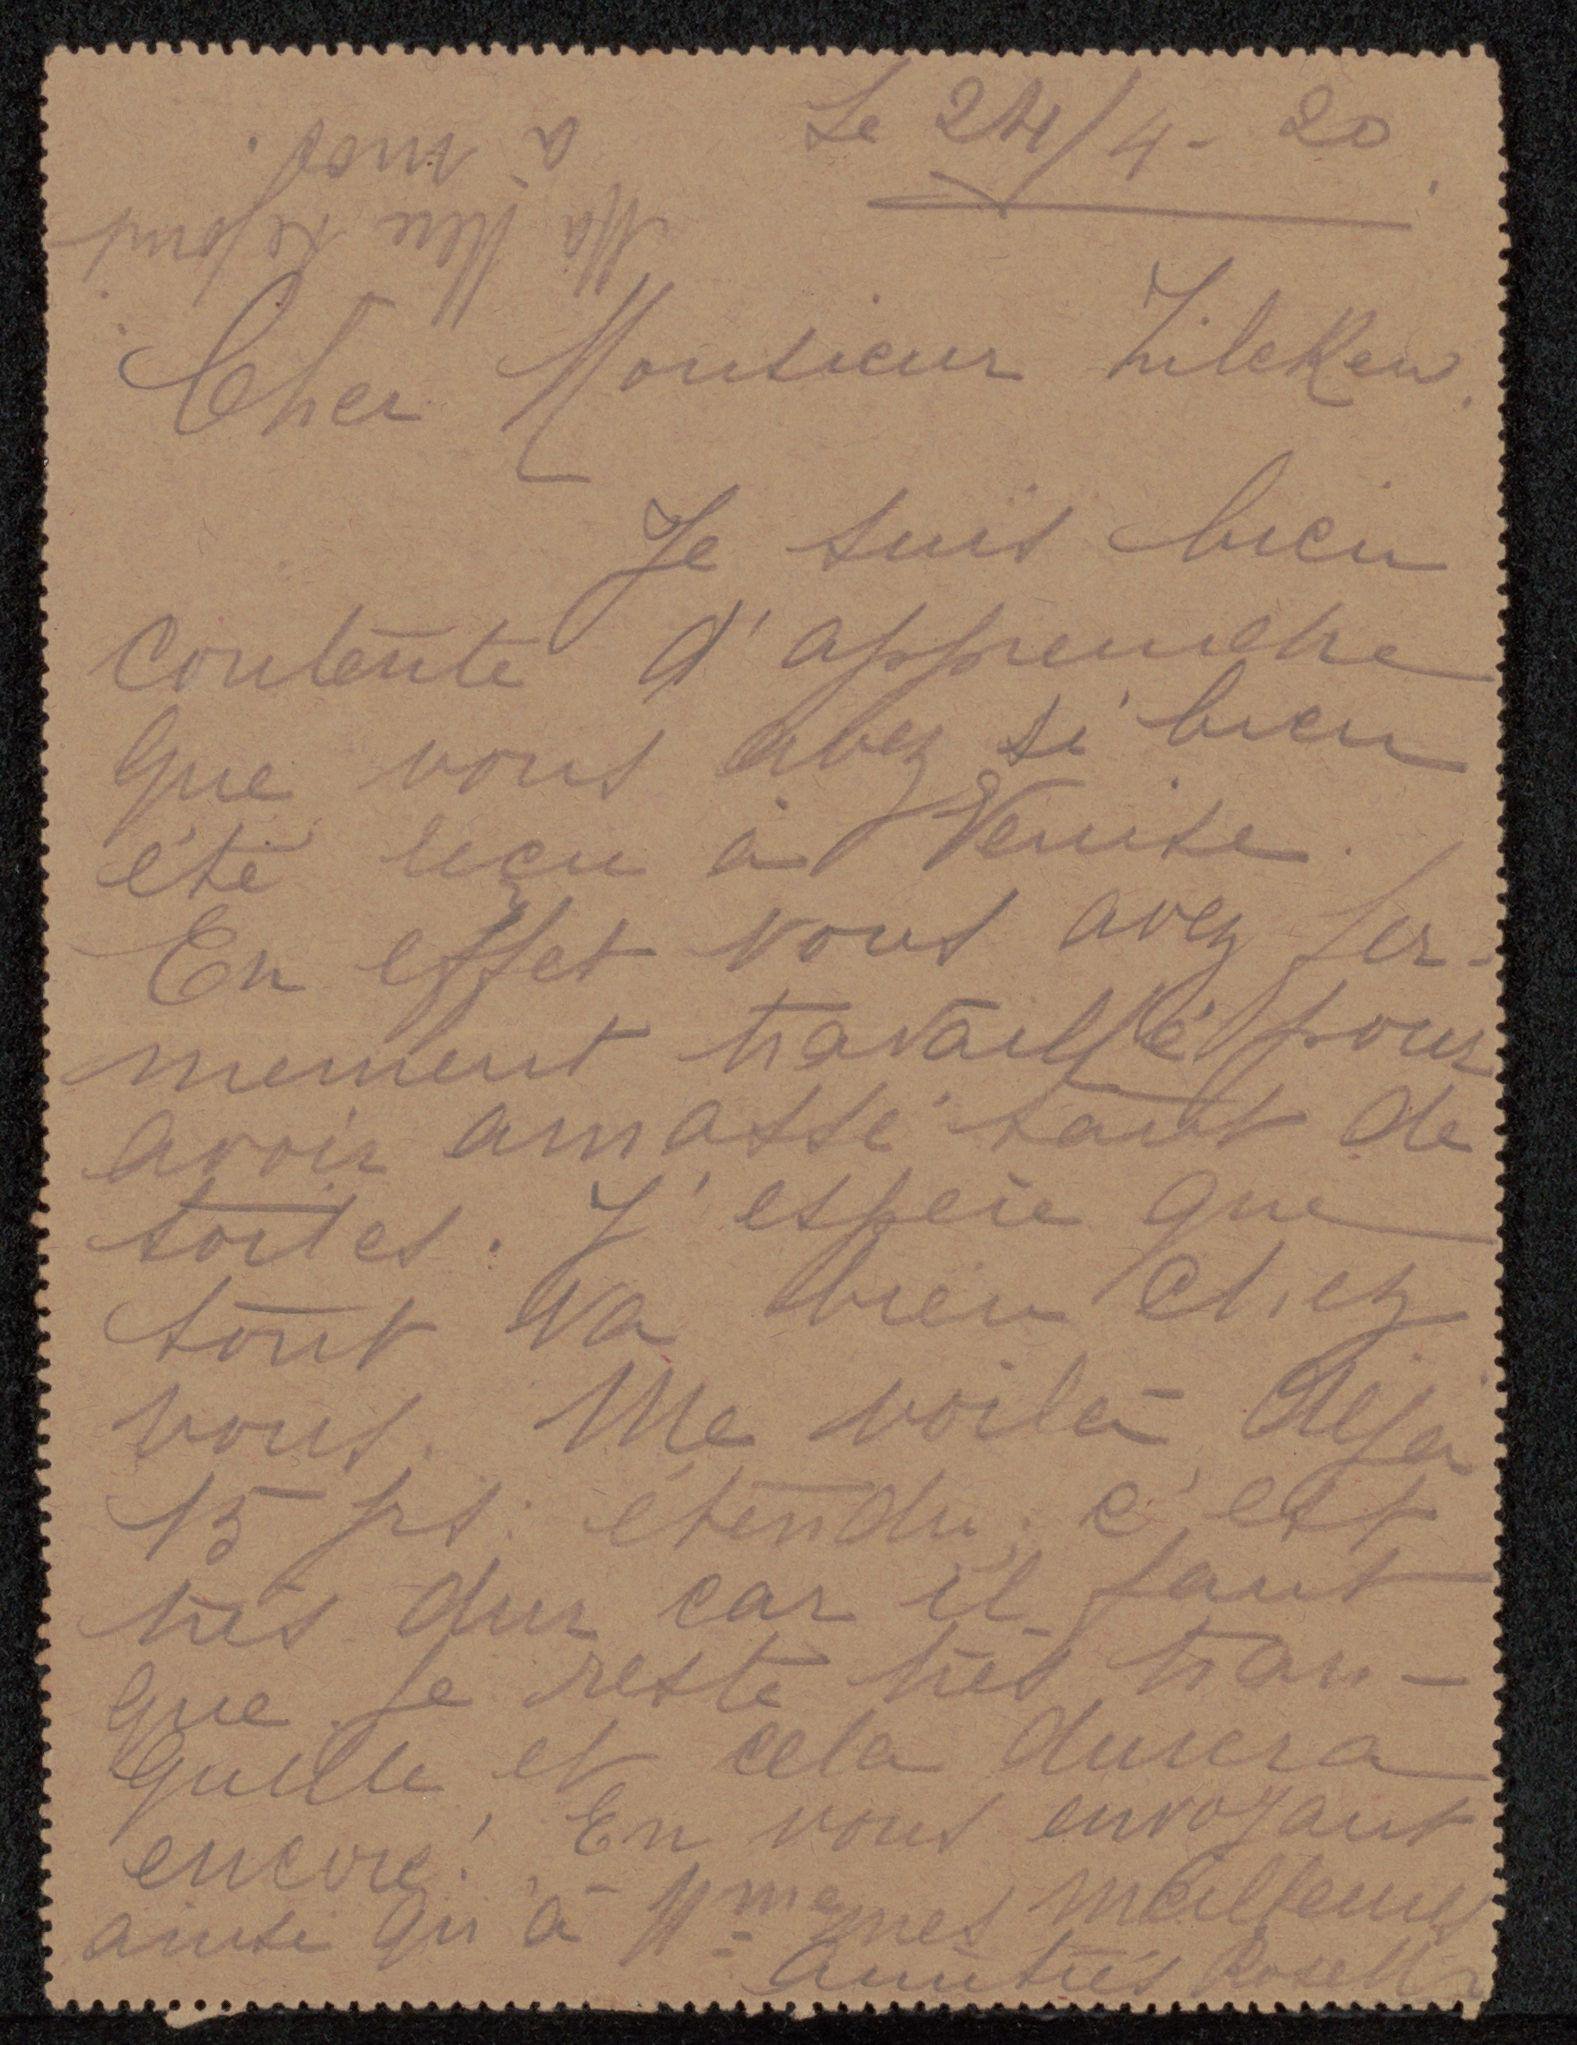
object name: letter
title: Brief aan Philip Zilcken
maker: rose imel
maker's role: draughtsman, painter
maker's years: 1901-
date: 1920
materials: paper, pencil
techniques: writing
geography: scheveningen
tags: the hague, painter, draughtsman, philip zilcken, venice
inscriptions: collector's mark: ‘RPK’